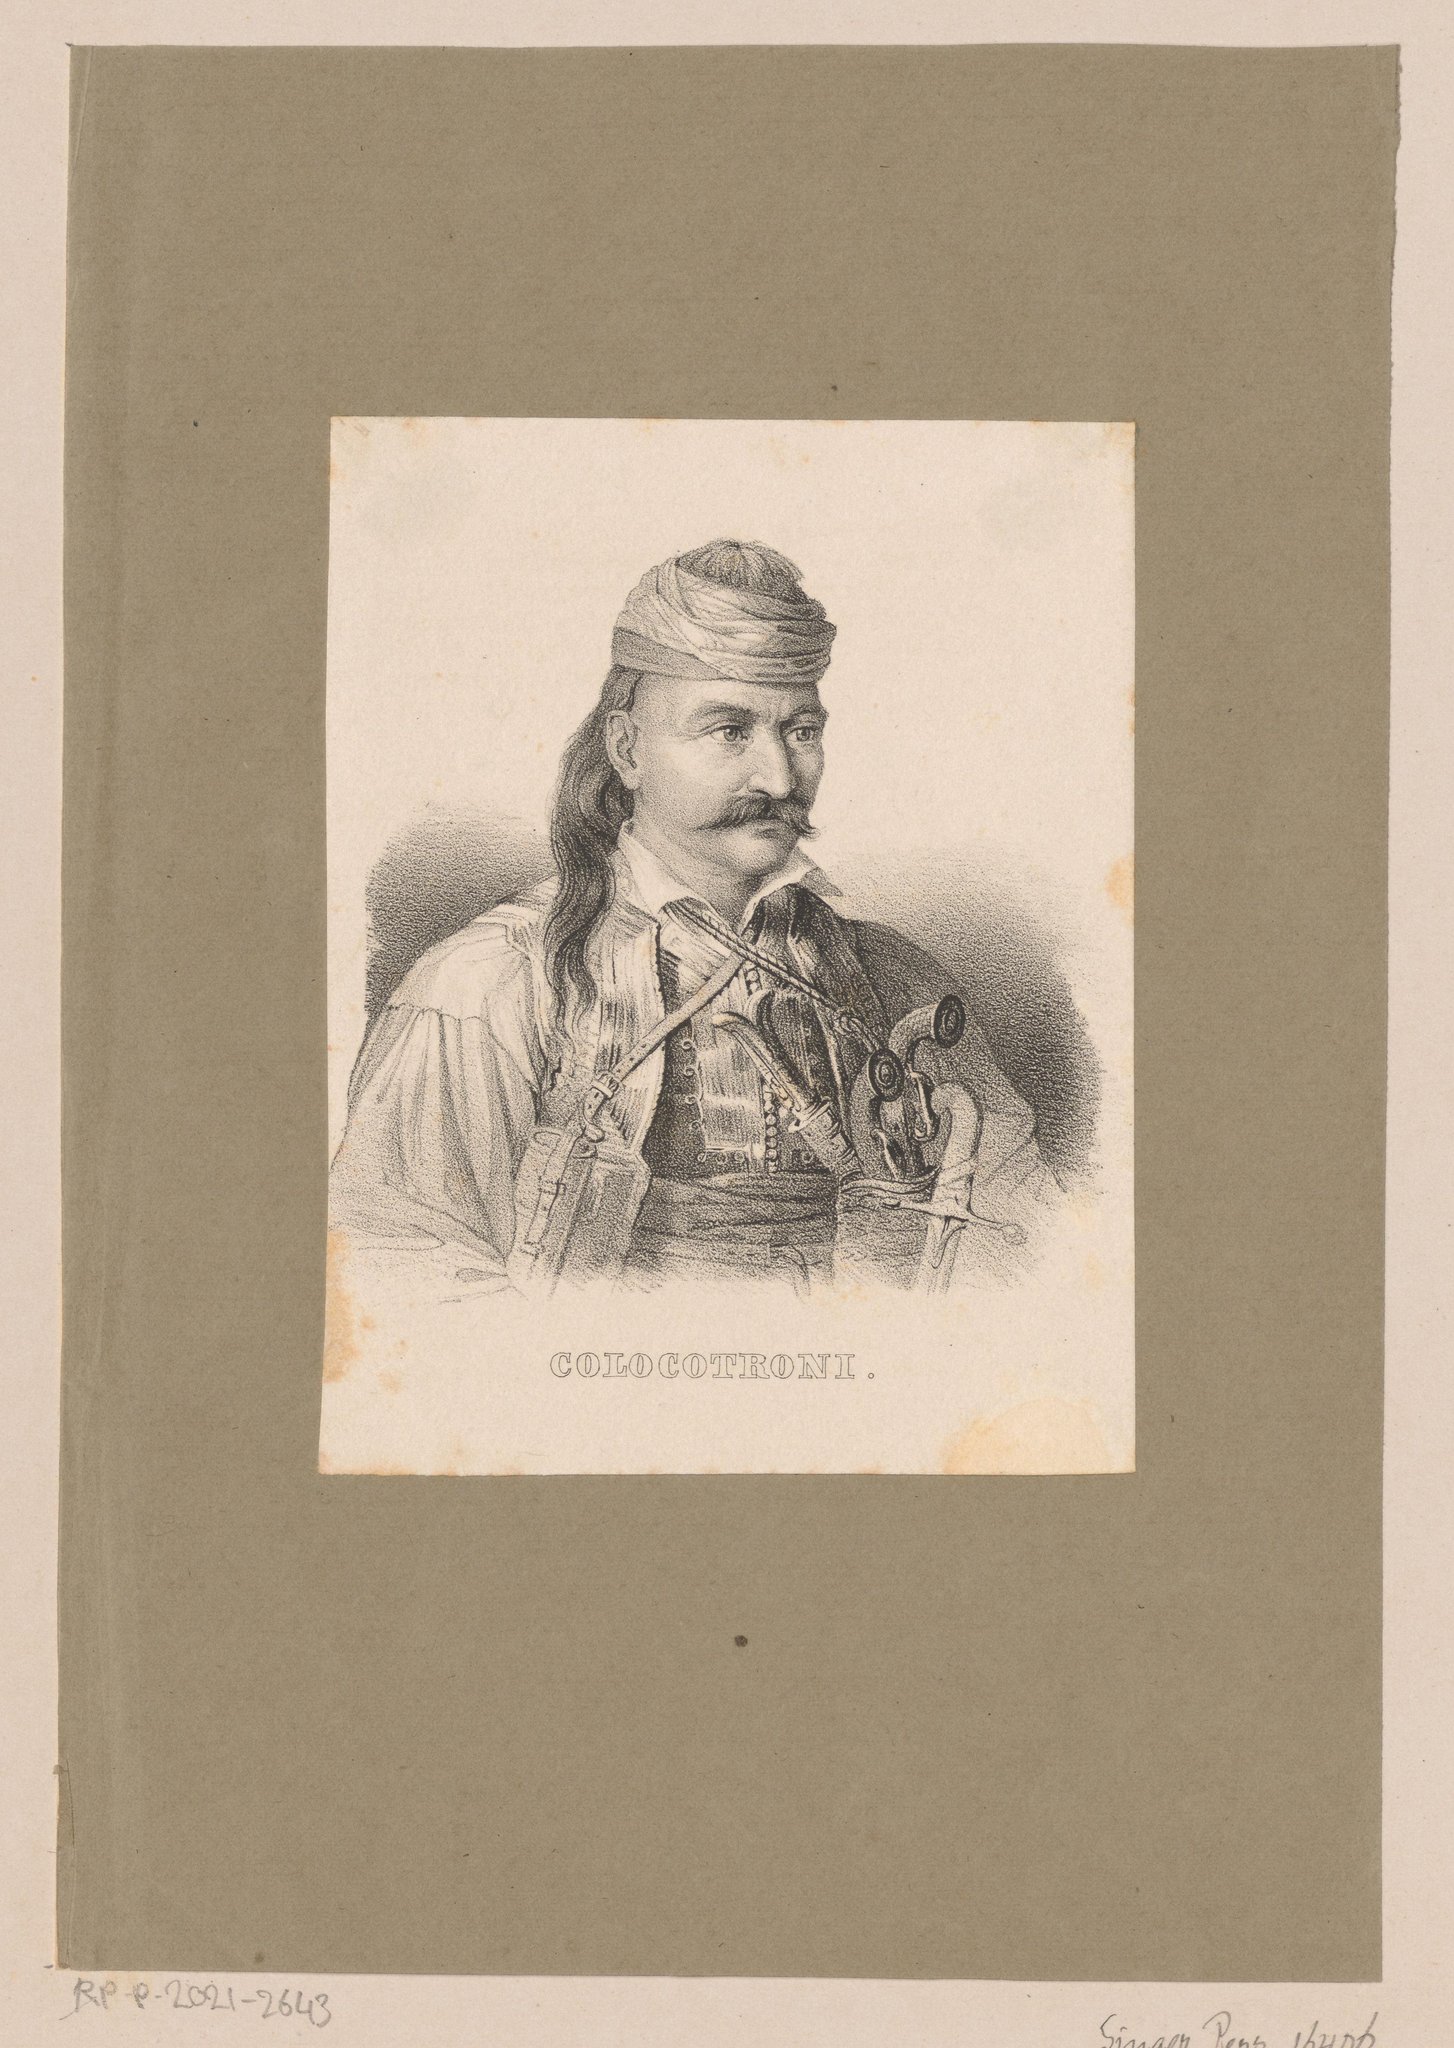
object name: print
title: Portret van Theodoros Kolokotronis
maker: Anonymous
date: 1820-1849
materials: paper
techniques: lithograph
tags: historical persons, hacking and thrusting weapons: sword